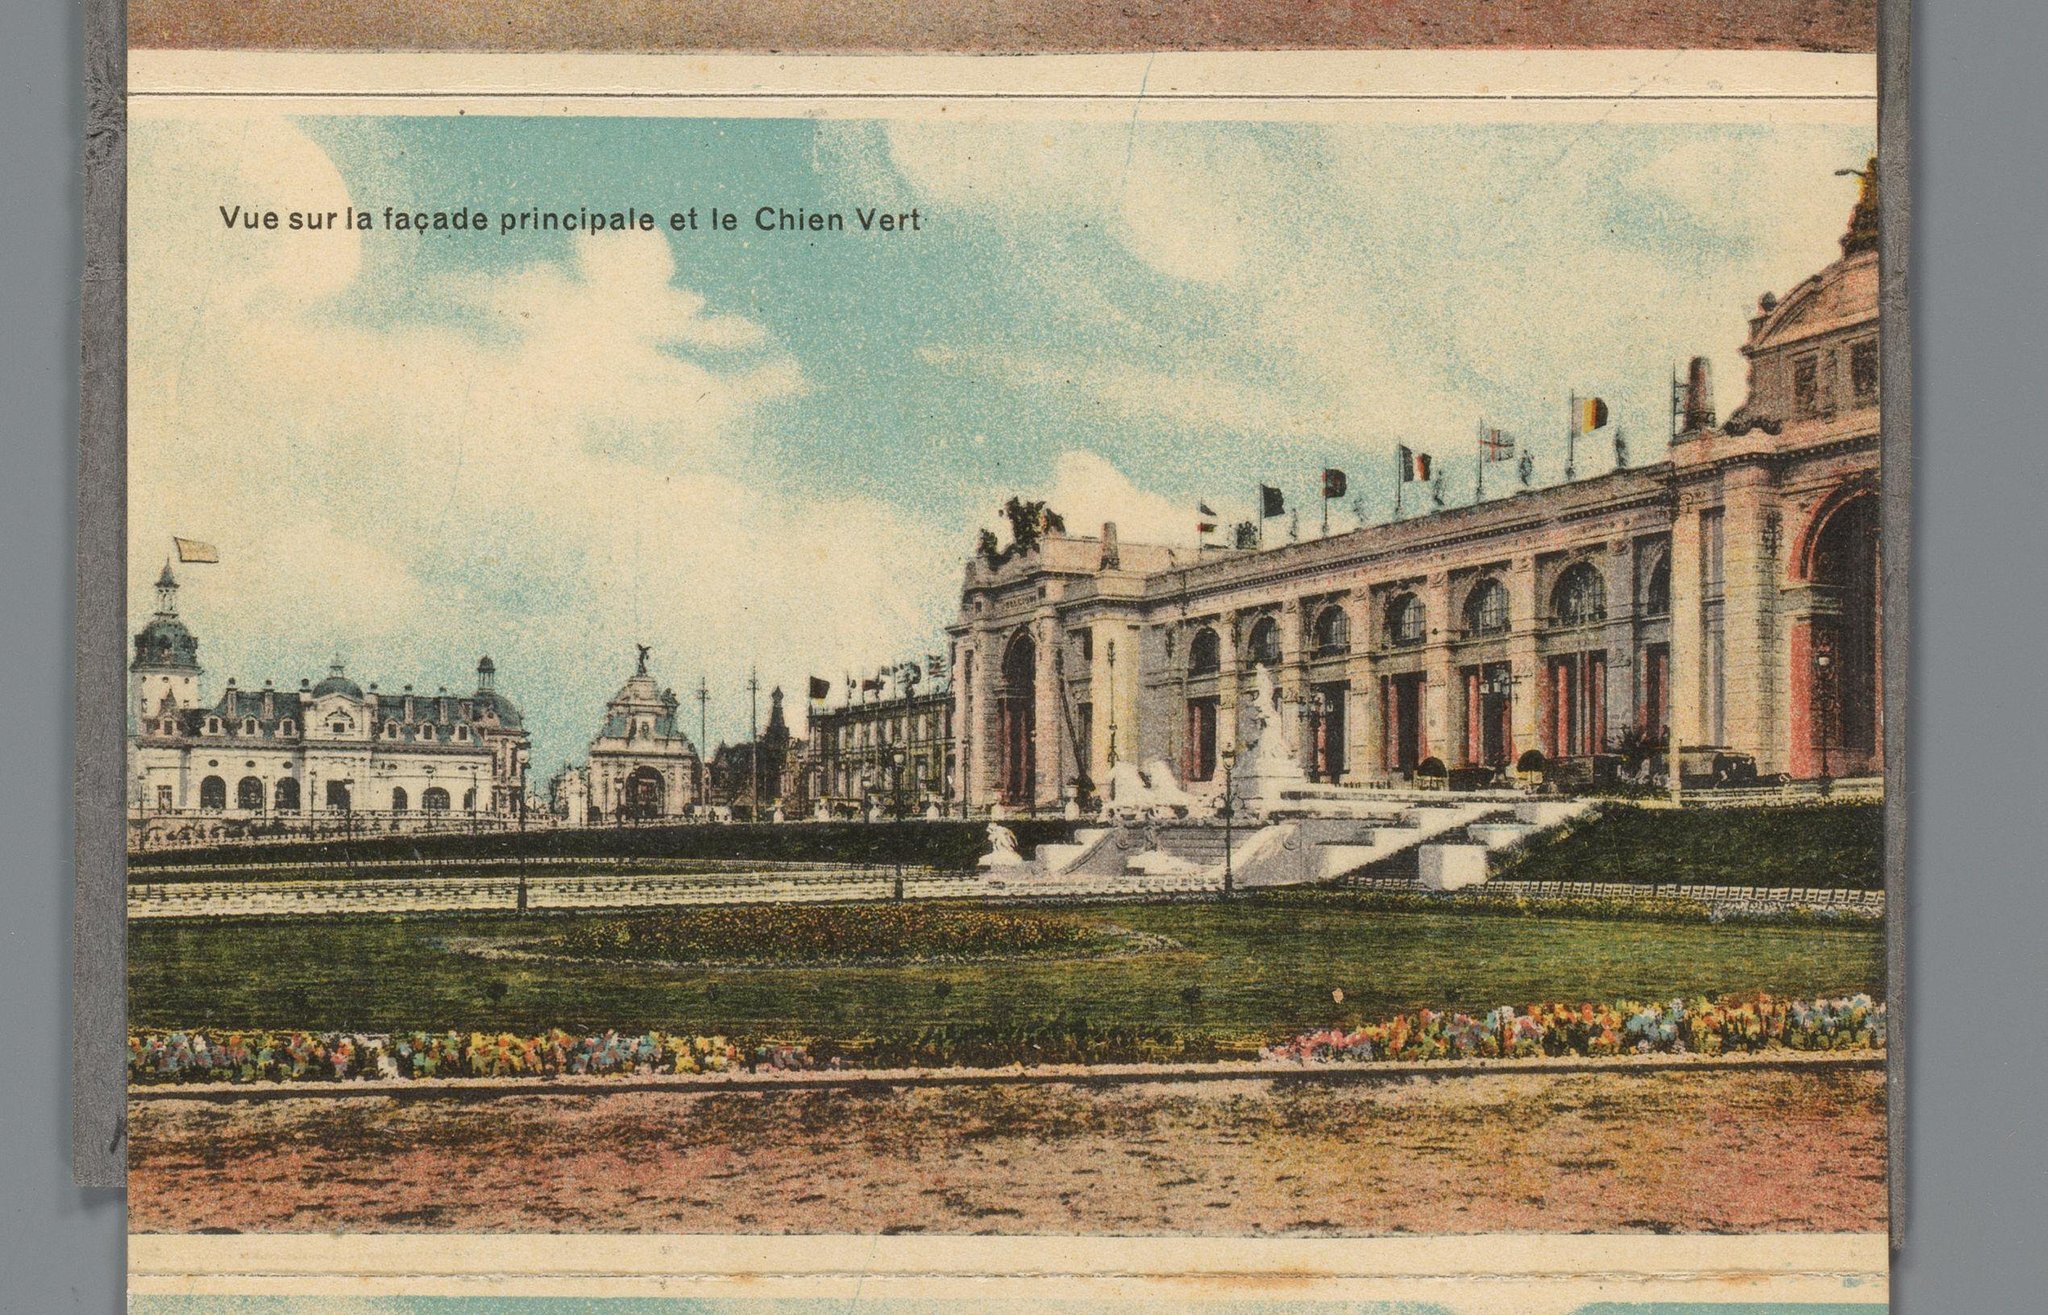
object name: photomechanical print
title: Vue sur la façade principale et le Chien Vert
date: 1910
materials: cardboard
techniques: photograph, lithograph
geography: brussels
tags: park, world fair, world exhibition, civic architecture; edifices; dwellings, brussels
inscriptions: date